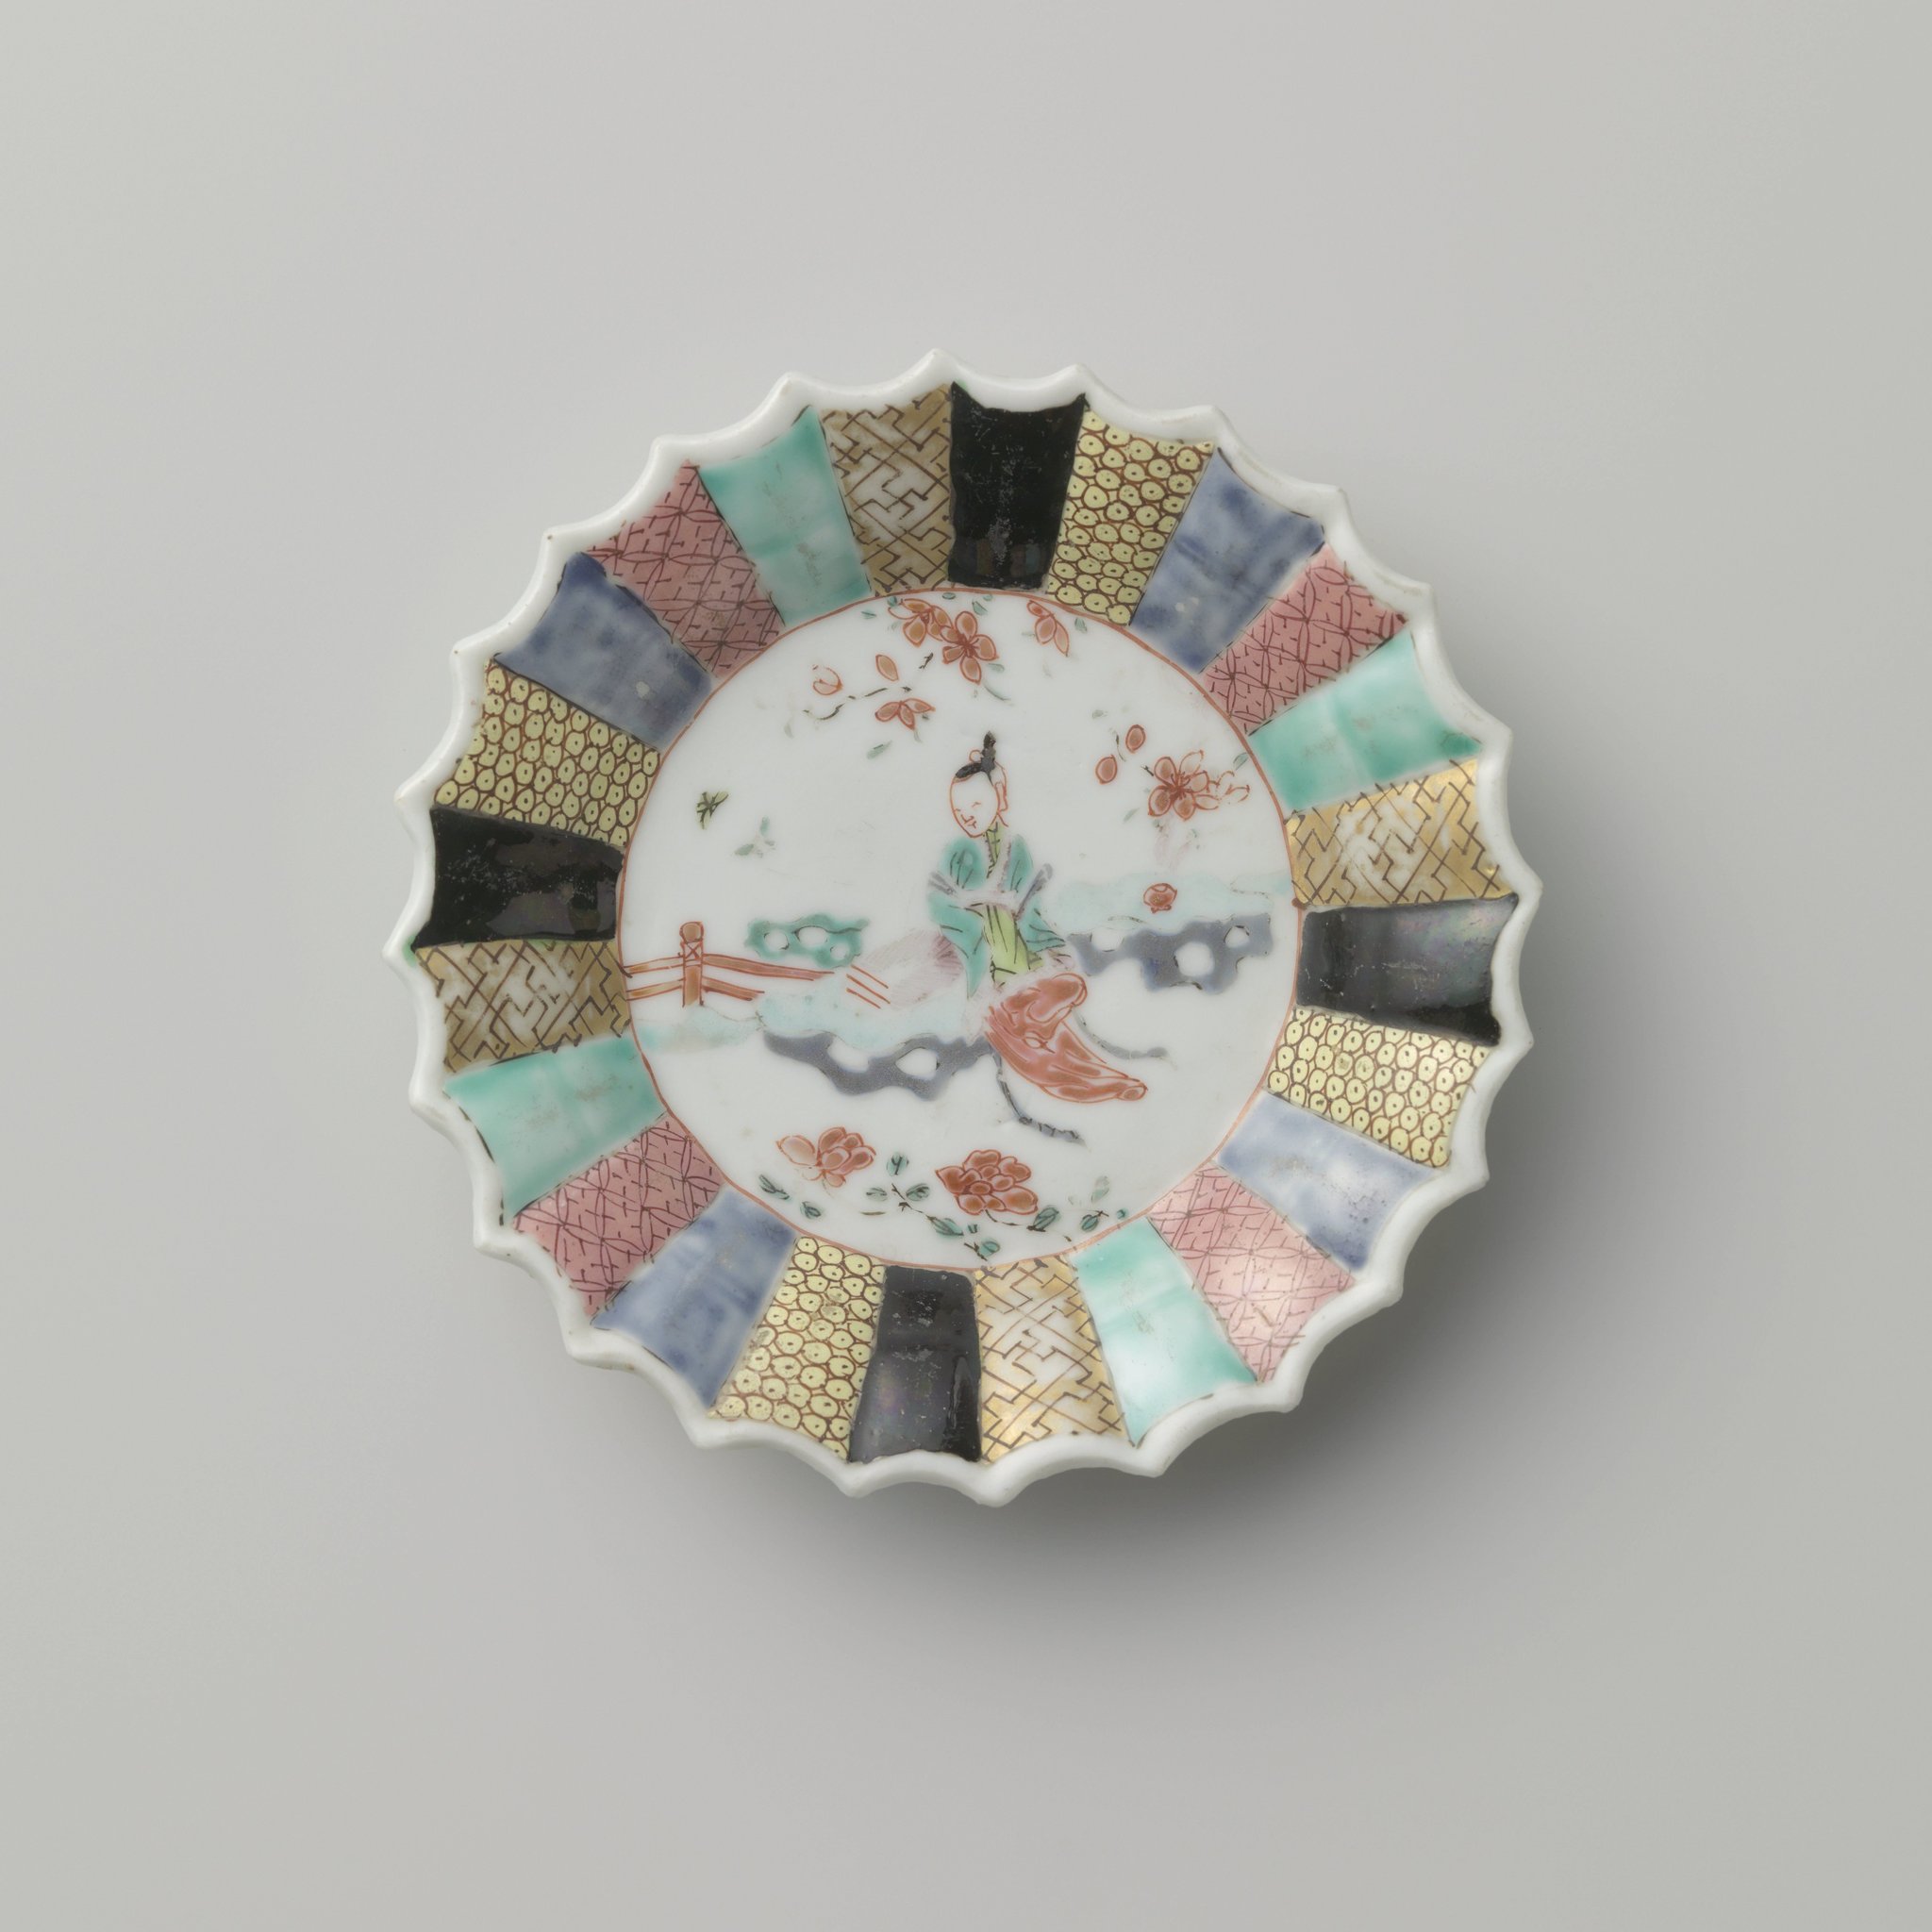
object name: kop en schotel, kop en schotel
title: Saucer with a woman in a garden and diaper patterns on various colored grounds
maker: Anonymous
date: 1725-1749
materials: glaze, gold, paint, porcelain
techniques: firing, gilding, turning, vitrification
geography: china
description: Schotel van porselein met geribde wand en geschulpte rand, beschilderd op het glazuur in blauw, rood, roze, groen, geel, zwart en goud. Op het plat van de schotel een vrouw (lange lijs) zittend op een rots in een omheinde tuin met bloeiende planten; de rand verdeeld in smalle vakken met servetwerk op verschillend gekleurde achtergronden. Famille rose.